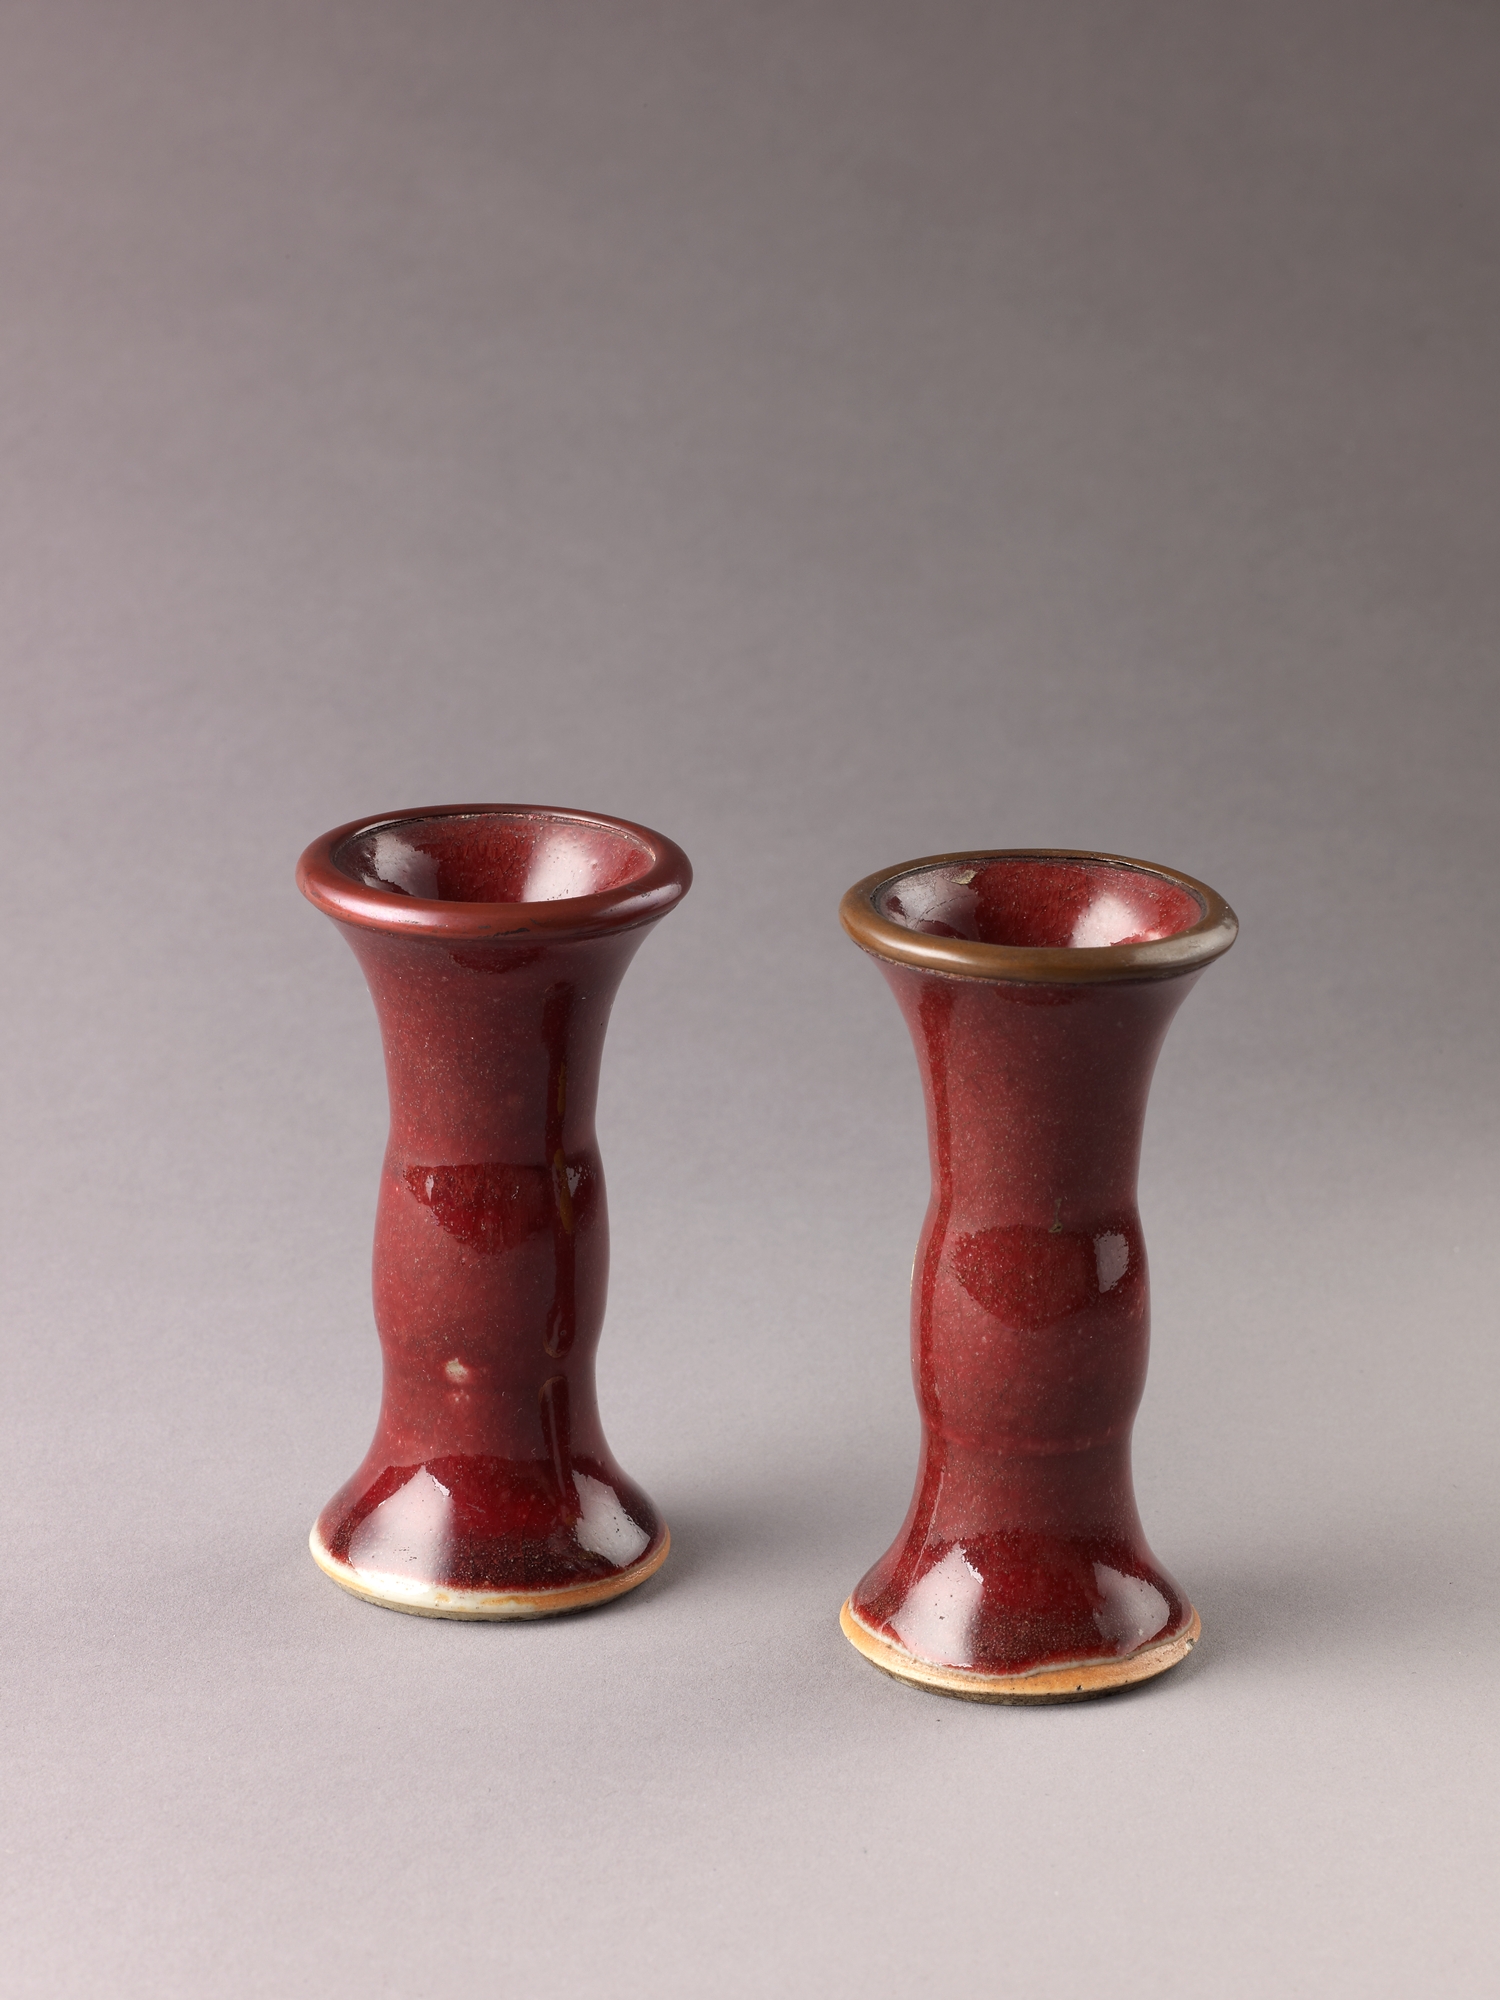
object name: vase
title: Small vase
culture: chinese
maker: chinese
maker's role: artist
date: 1801-1900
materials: glaze, porcelain